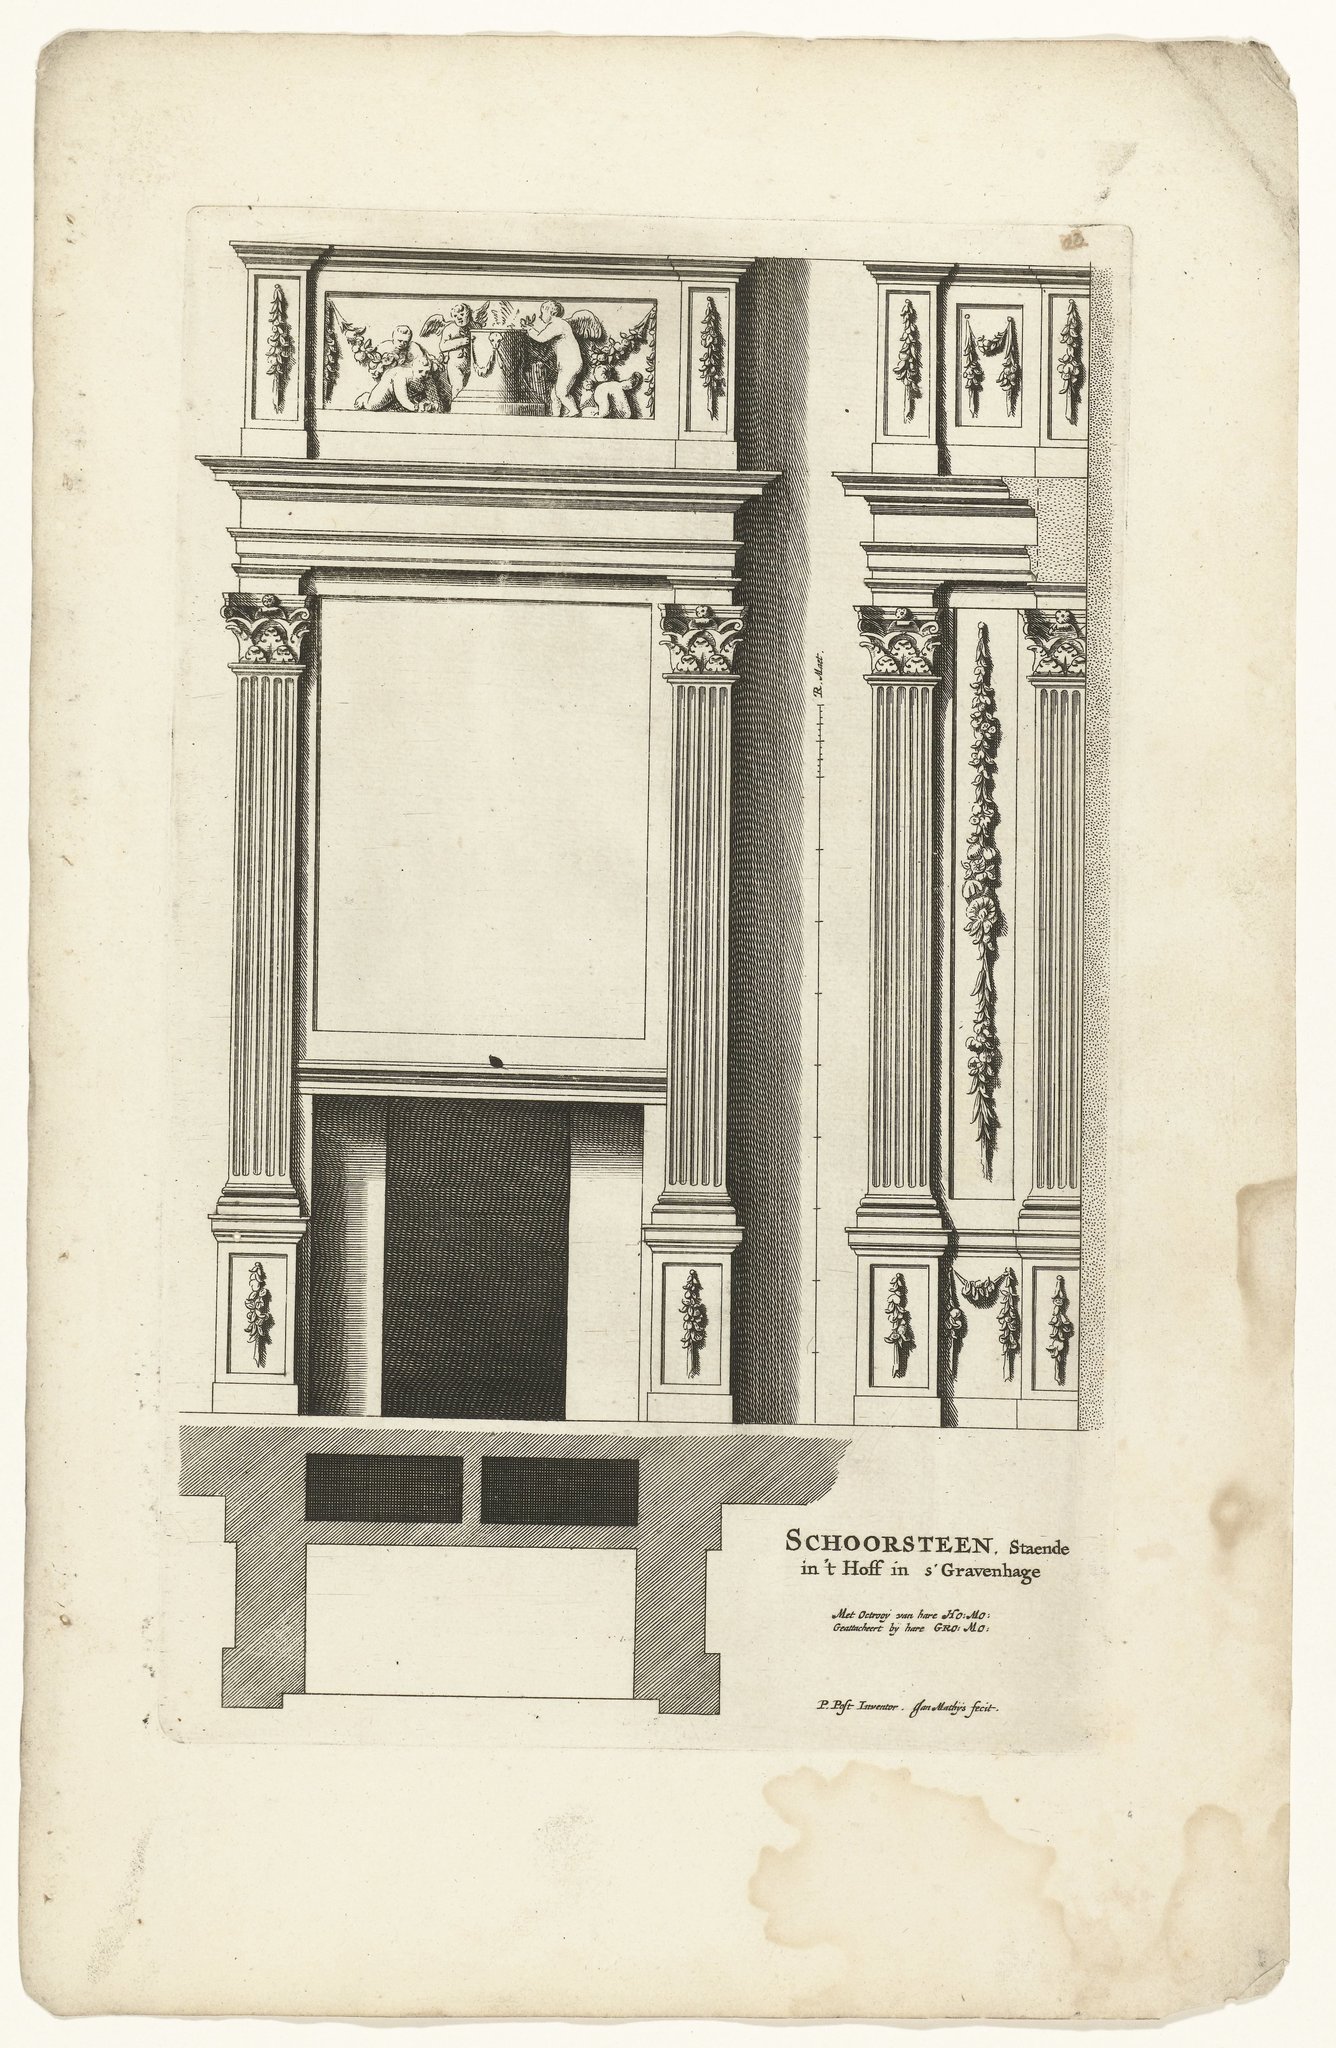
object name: print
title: Onderboezem in Paleis Noordeinde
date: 1664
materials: paper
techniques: engraving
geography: the hague